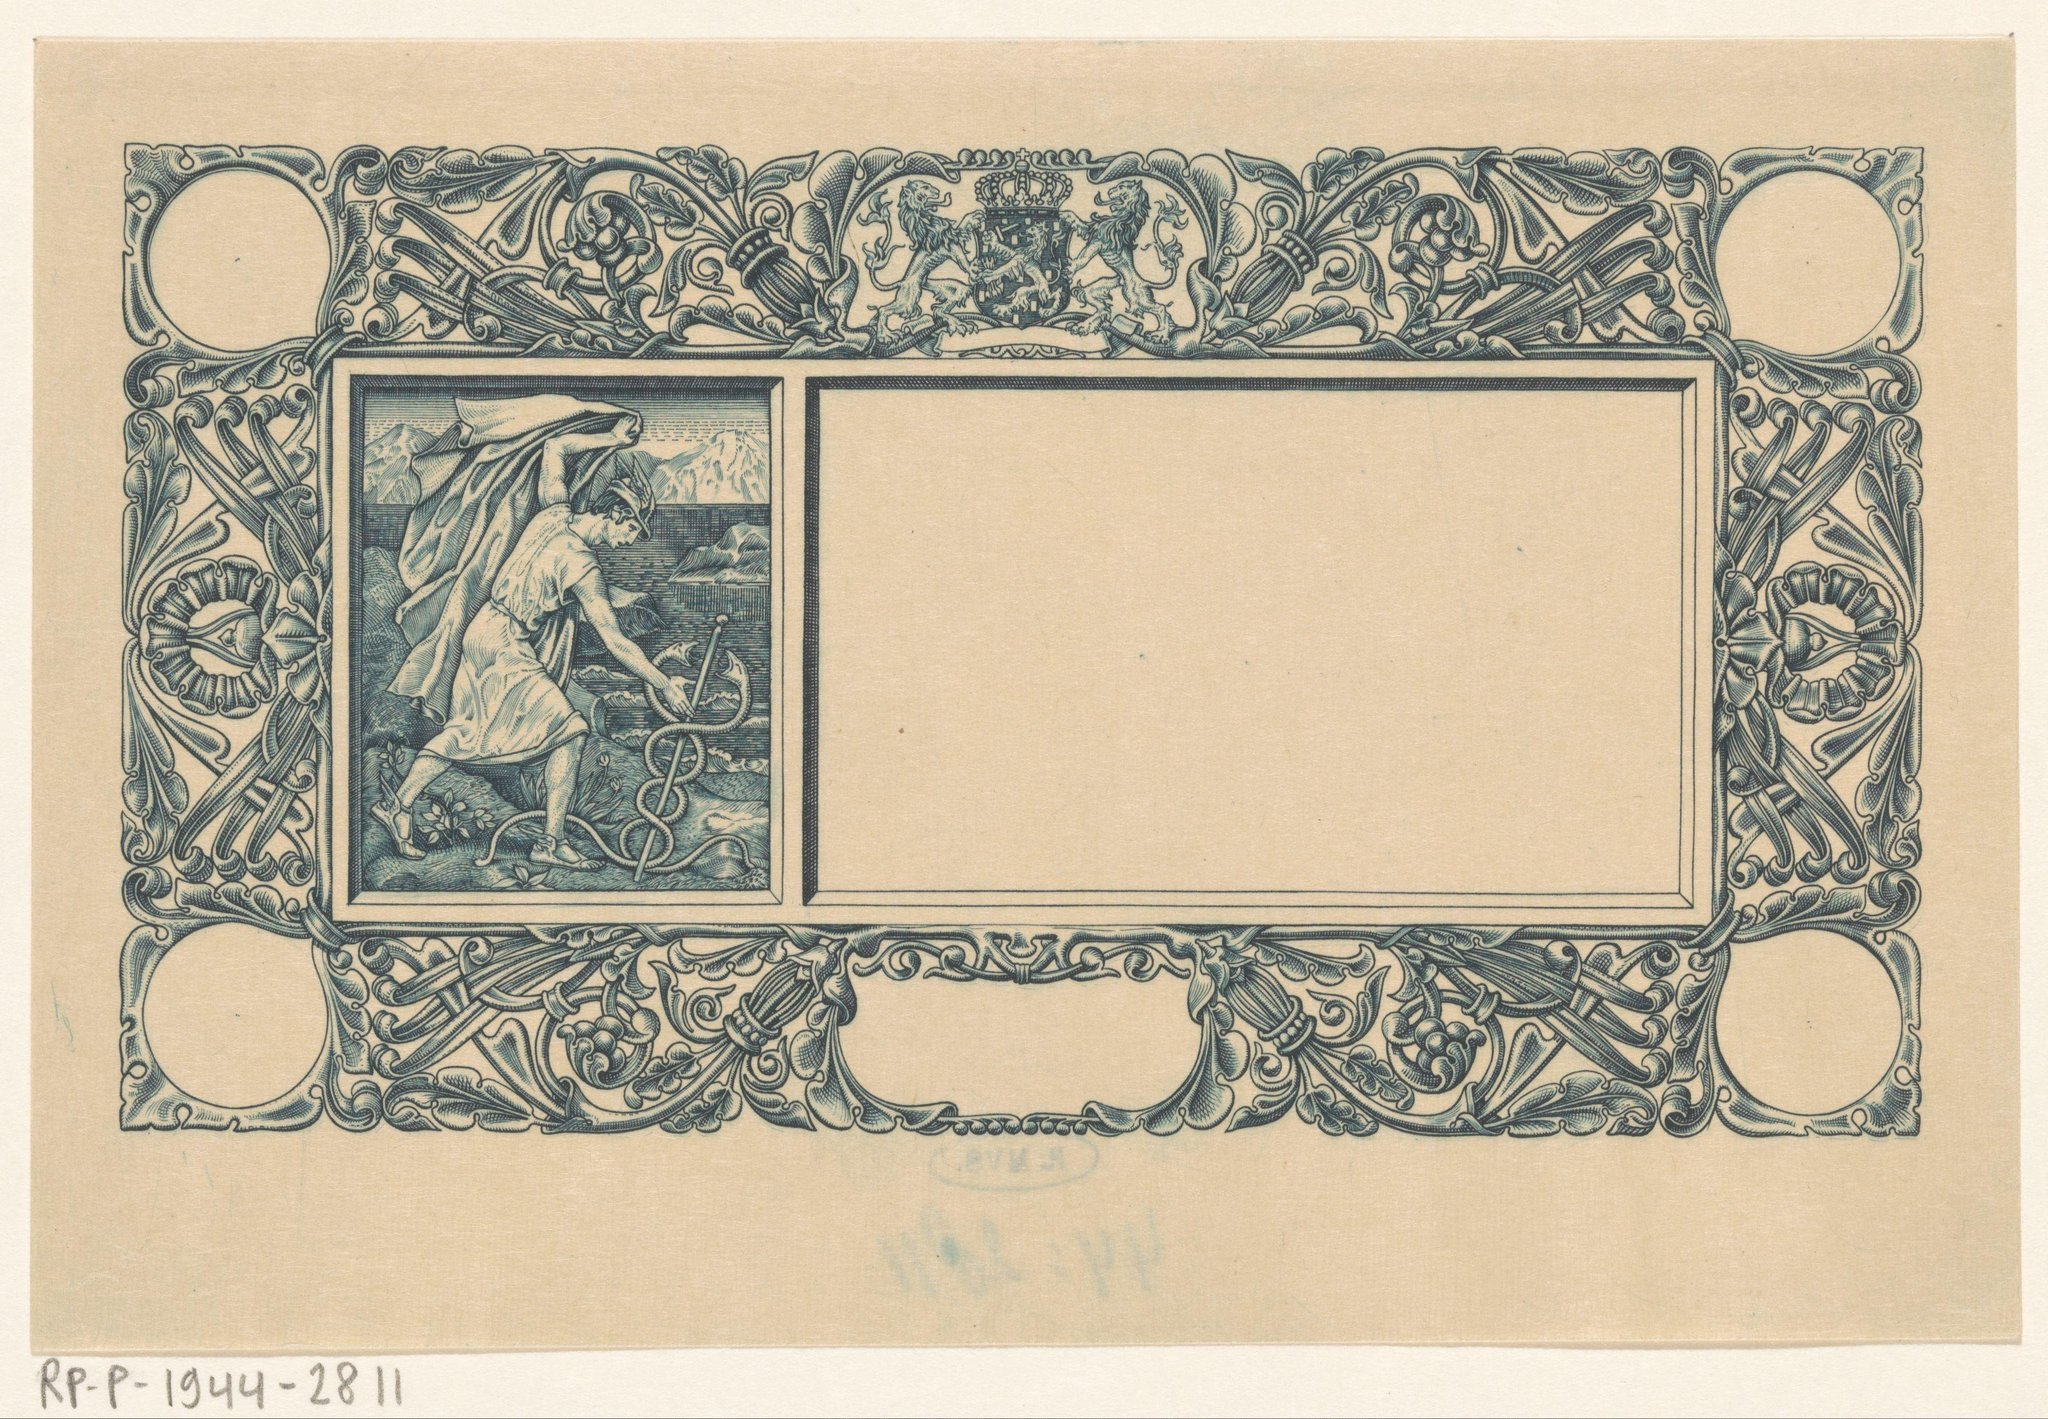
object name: waardepapier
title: Voorzijde van een bankbiljet van vijfentwintig gulden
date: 1910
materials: paper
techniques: engraving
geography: amsterdam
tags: ornaments ~ art, (story of) mercury (hermes)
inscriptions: collector's mark: Lugt 2228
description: Een rechthoekig kader, versierd met plantmotieven, waarin ruimte is opengelaten voor cijfers. In het midden een rechthoek die rechts is opengelaten voor tekst. Links Hermes, god van de handel, herkenbaar aan zijn gevleugelde sandalen, zijn gevleugelde petasus (hoed), en zijn caduceus, een door twee slangen omwonden staf.